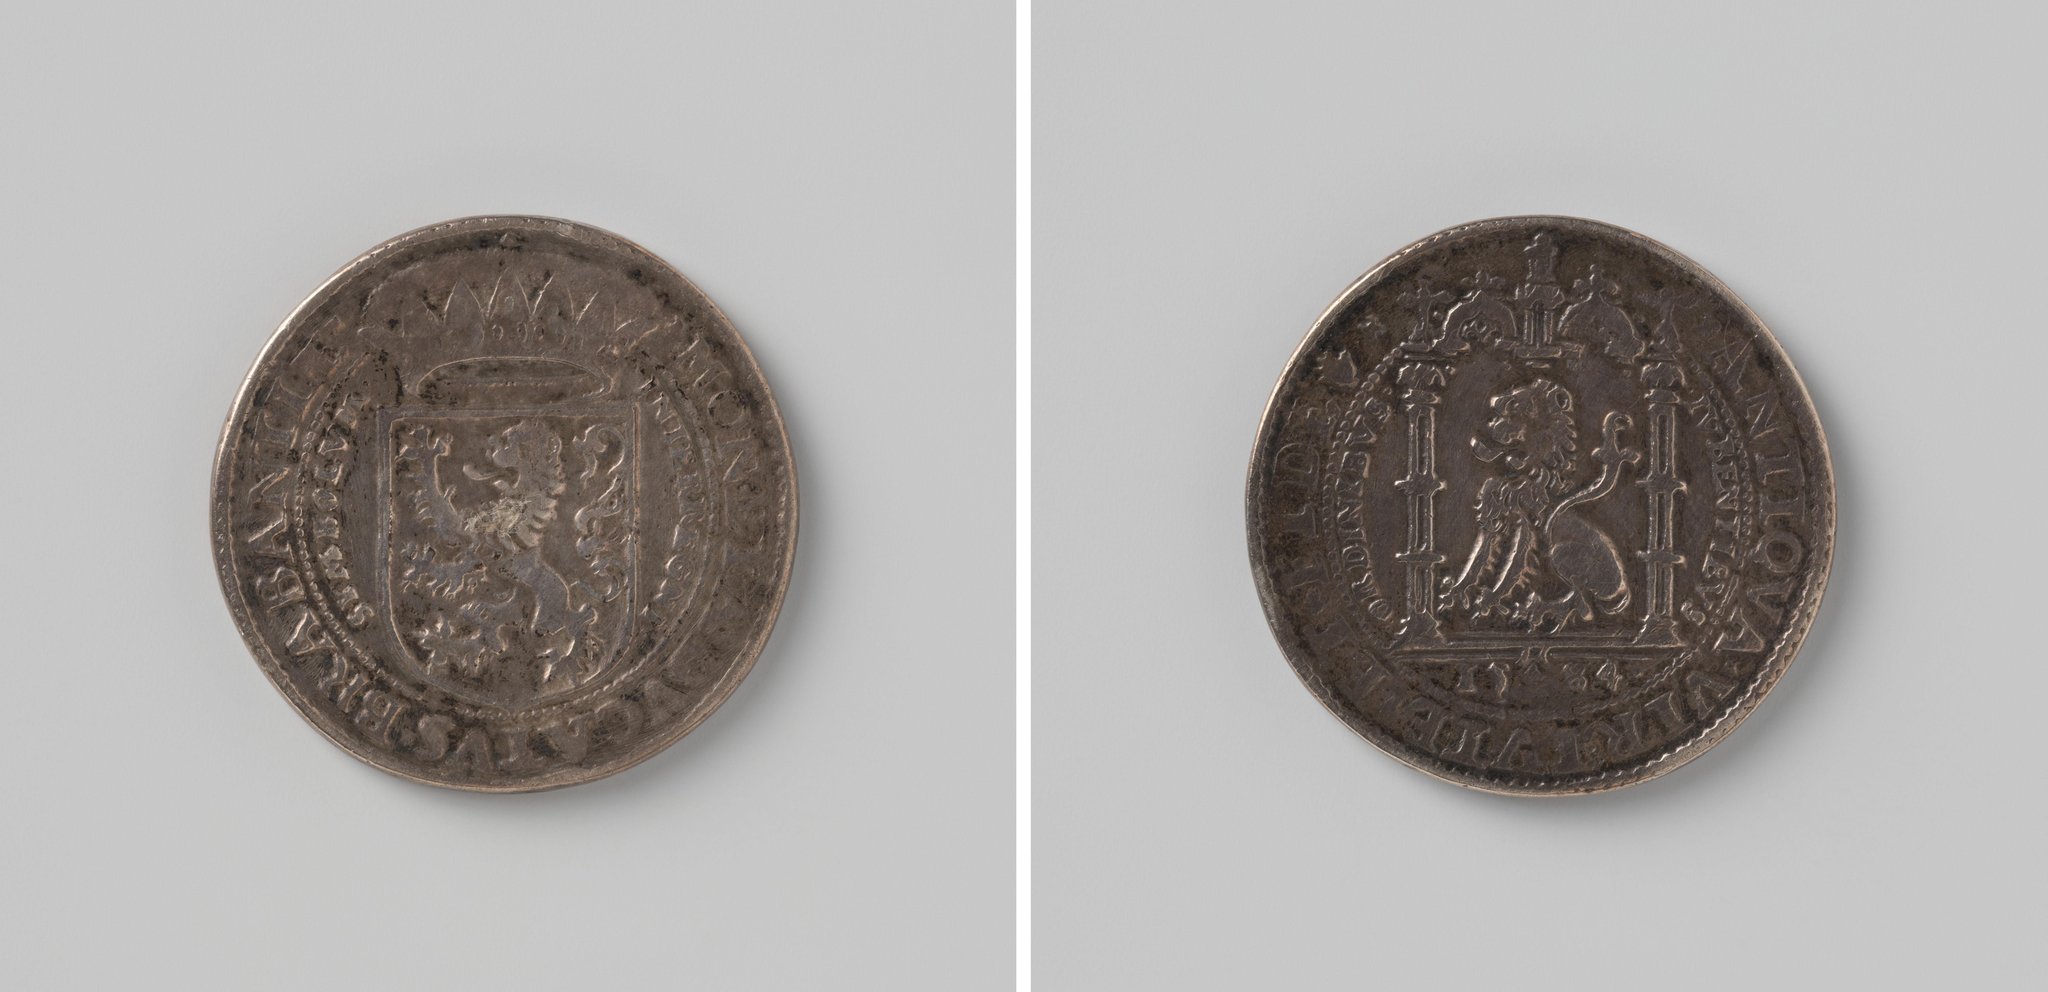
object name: medal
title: Vrij hertogdom Brabant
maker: Anonymous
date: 1584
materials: silver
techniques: striking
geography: brabant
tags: brabant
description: Zilveren penning. Voorzijde: gekroond wapenschild binnen tweeregelig omschrift. Keerzijde: leeuw, zittend binnen erepoort boven jaartal binnen omschrift